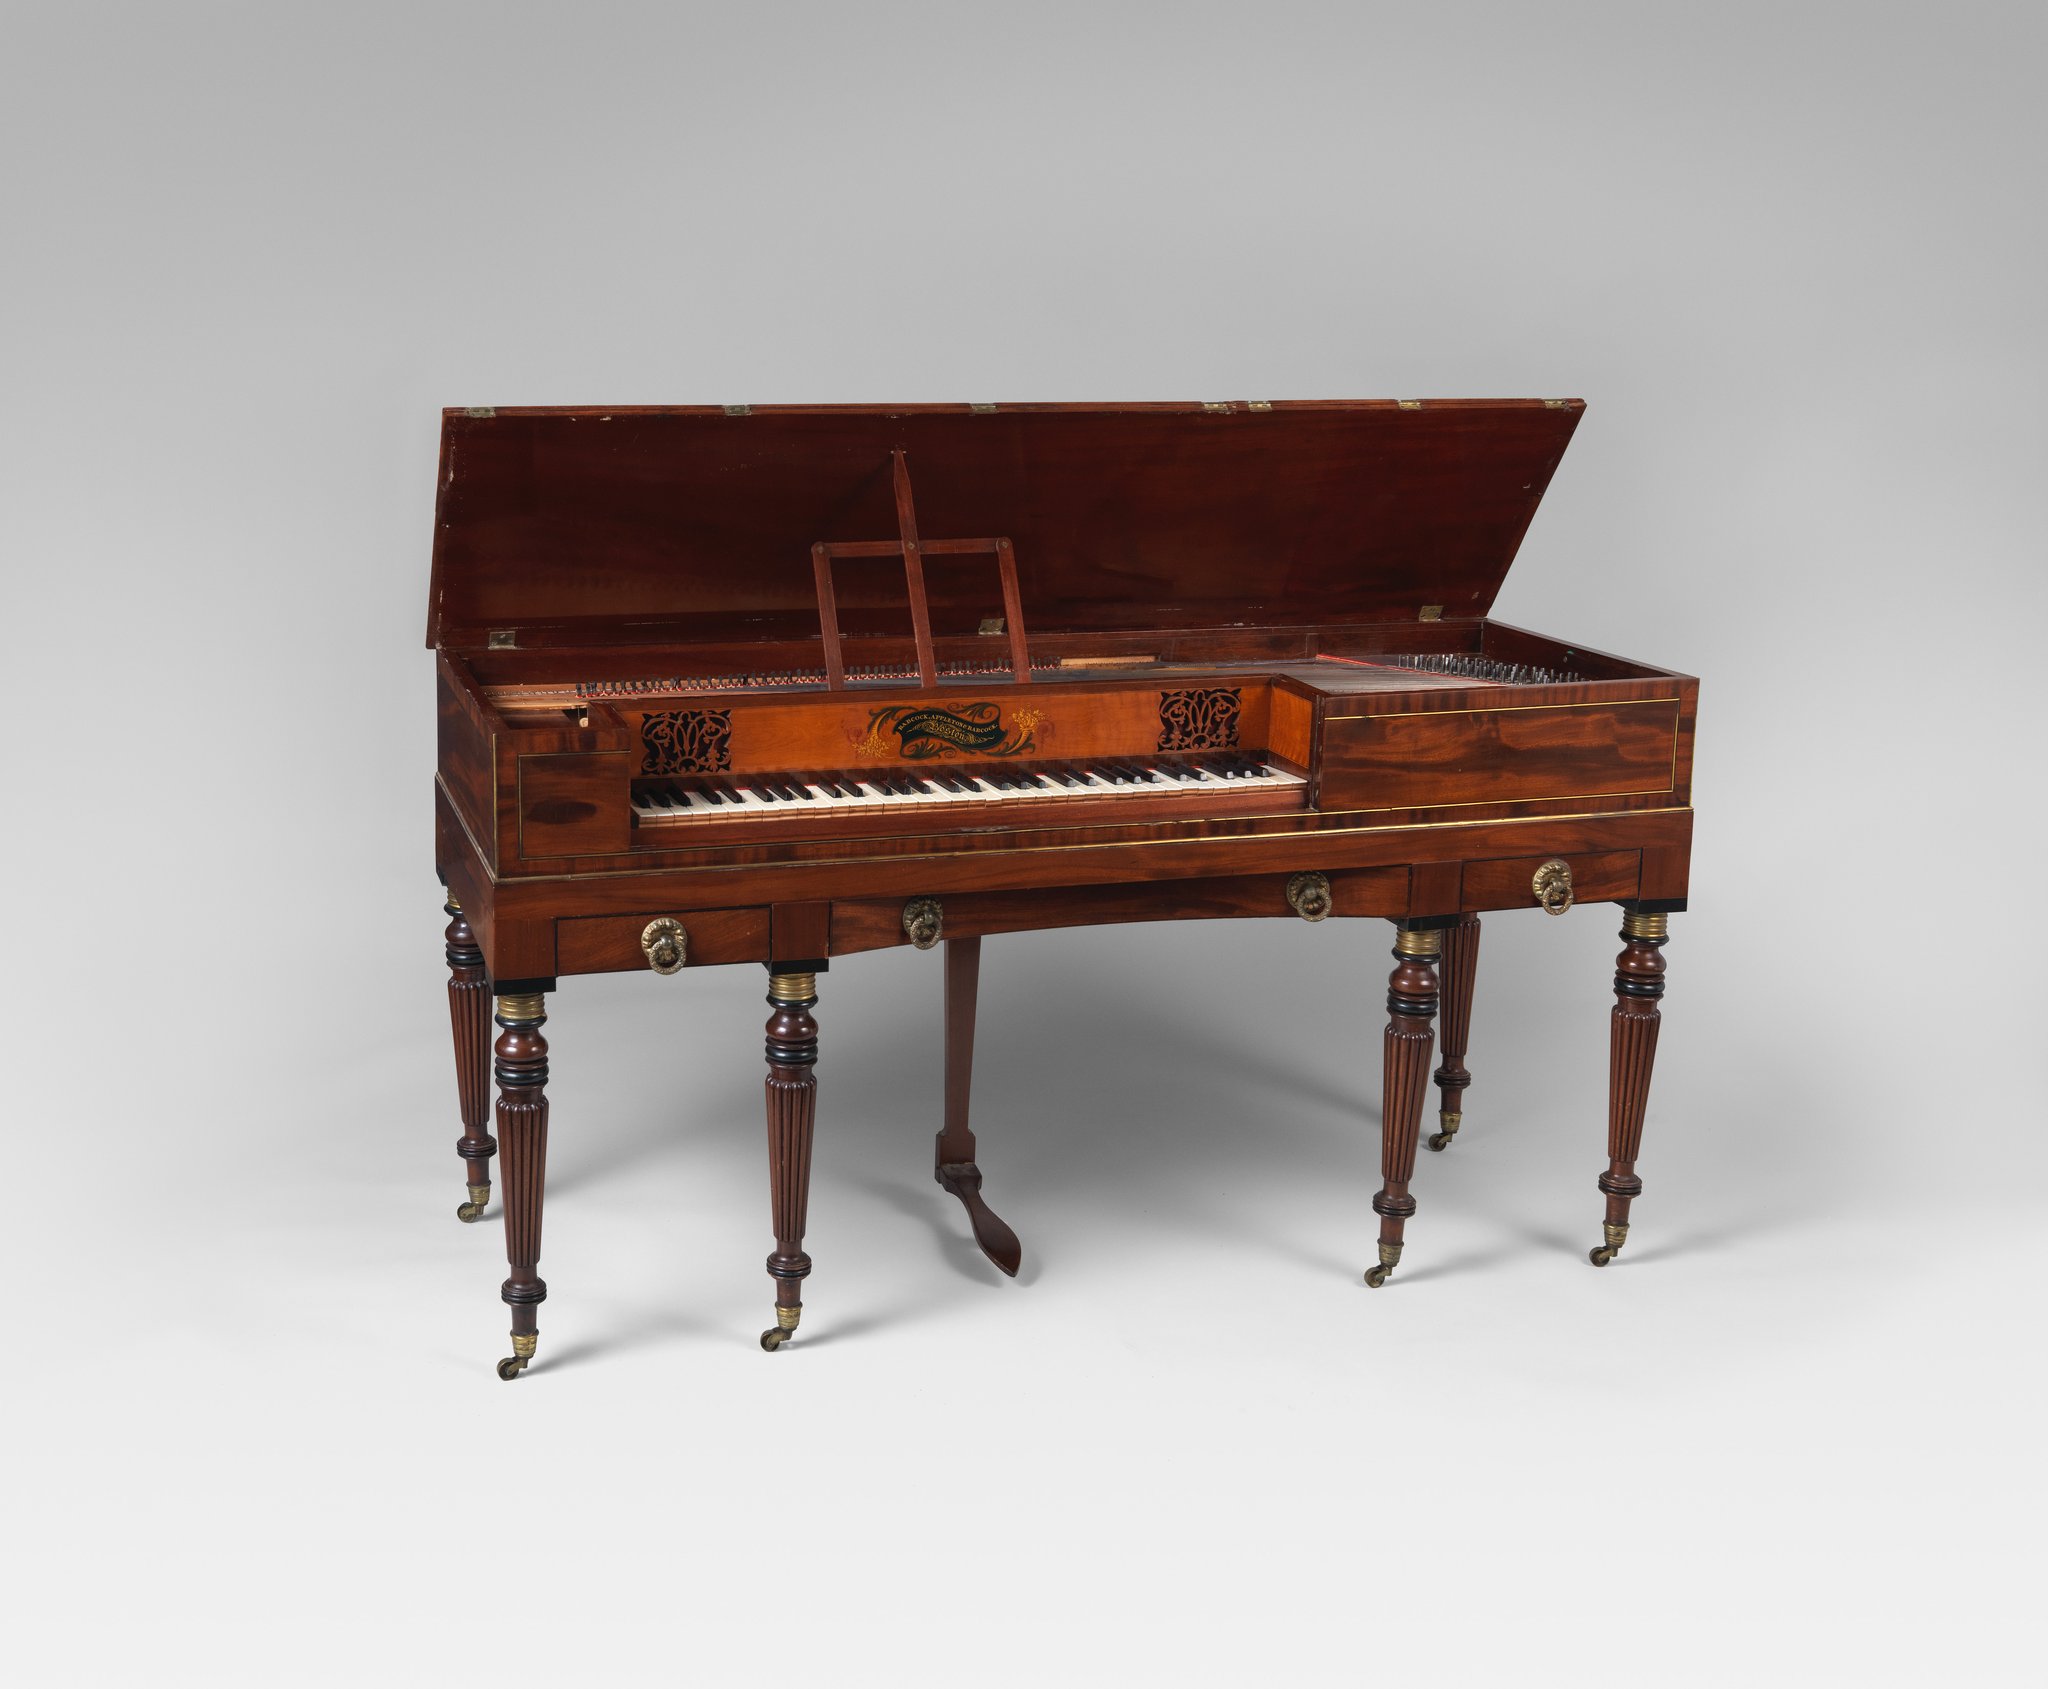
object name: square piano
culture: american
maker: babcock, appleton and babcock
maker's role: maker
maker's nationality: american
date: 1814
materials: wood, metal, textile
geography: united states